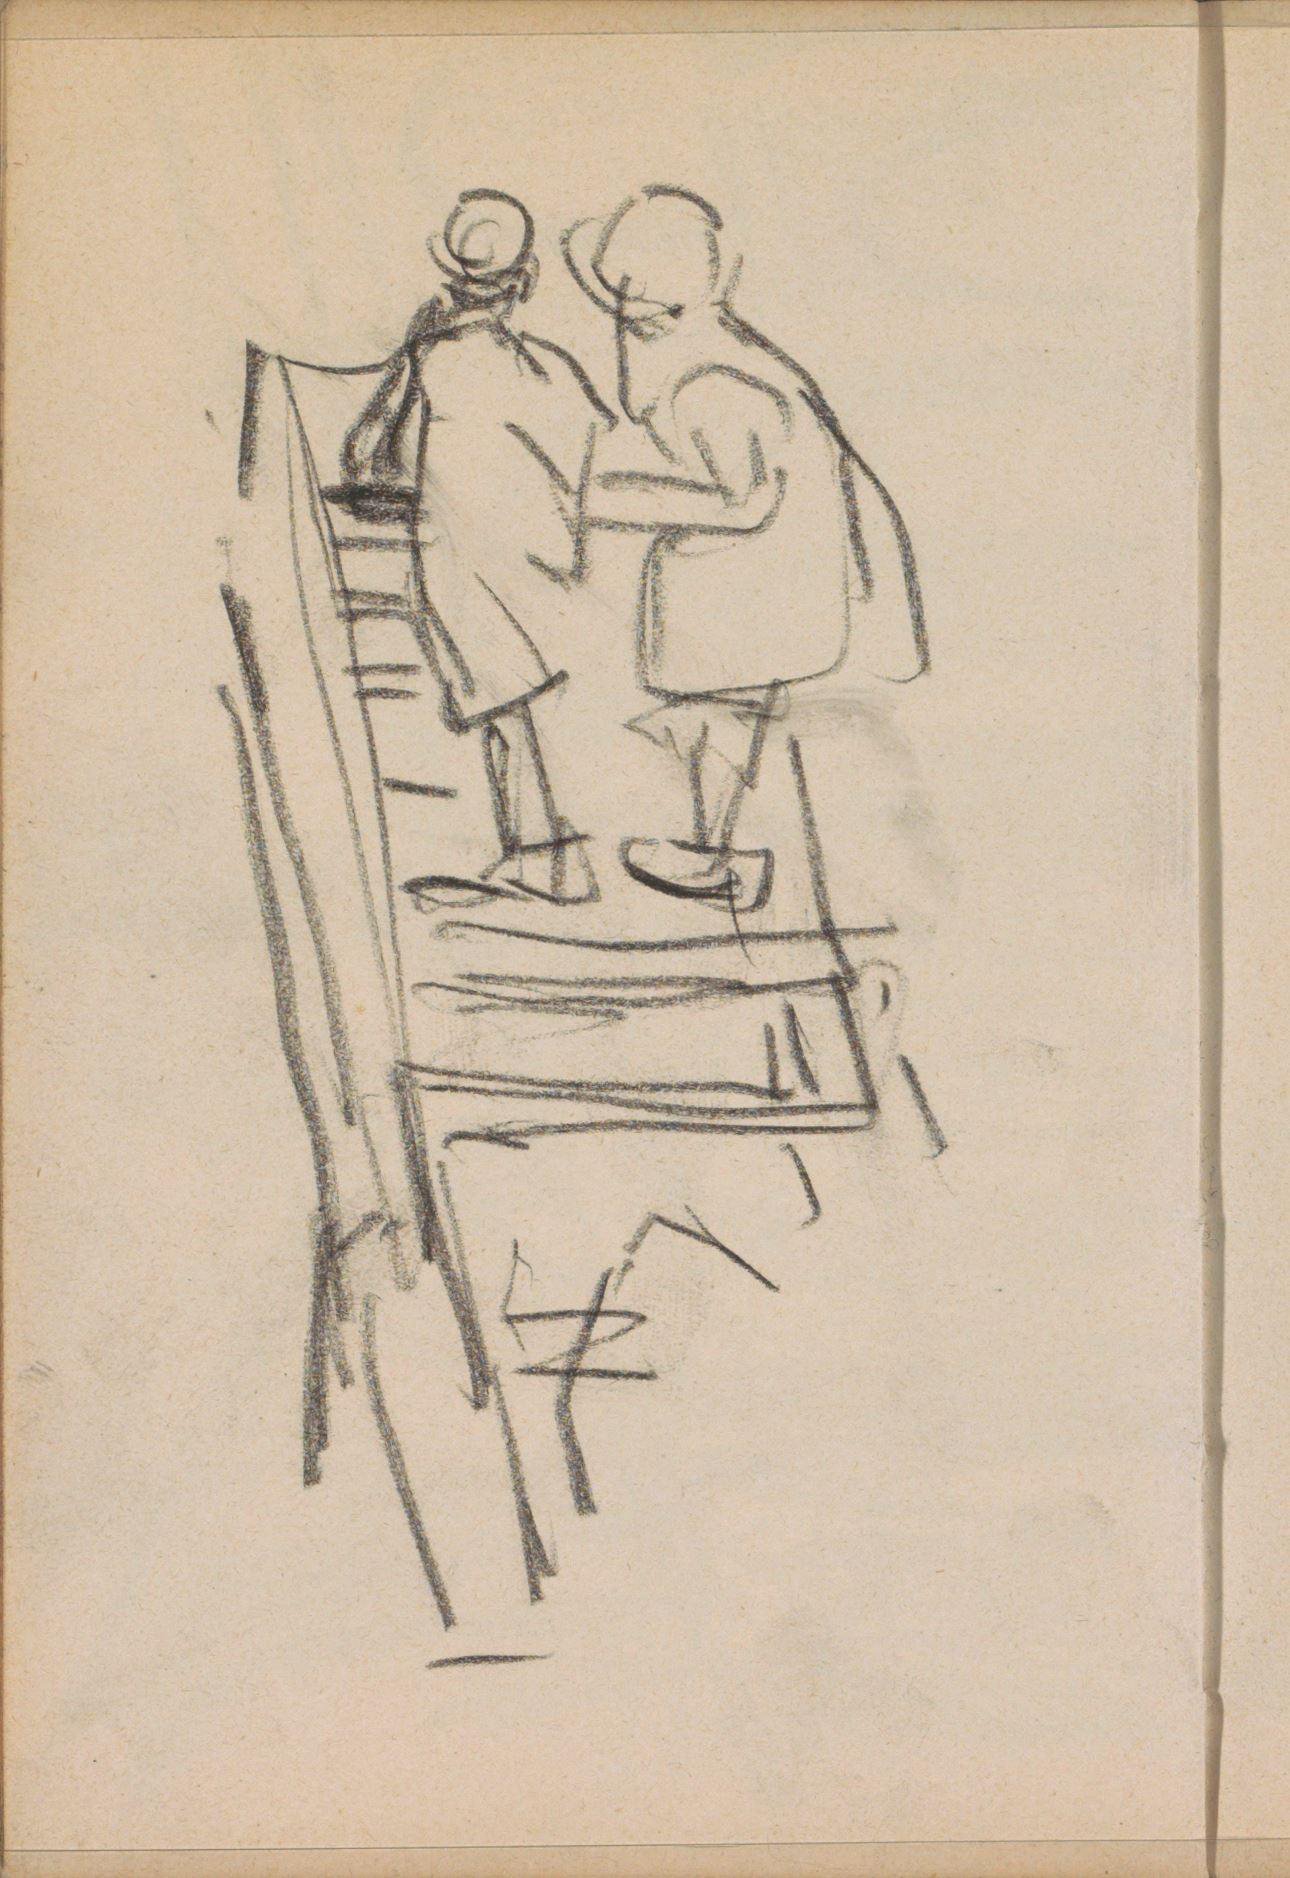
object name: sketchbook leaf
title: Twee figuren op een trap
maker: george hendrik breitner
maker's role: draughtsman, painter, print maker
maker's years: 1857-1923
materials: chalk, paper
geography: amsterdam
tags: staircase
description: Pagina 43 uit een schetsboek met 46 bladen.